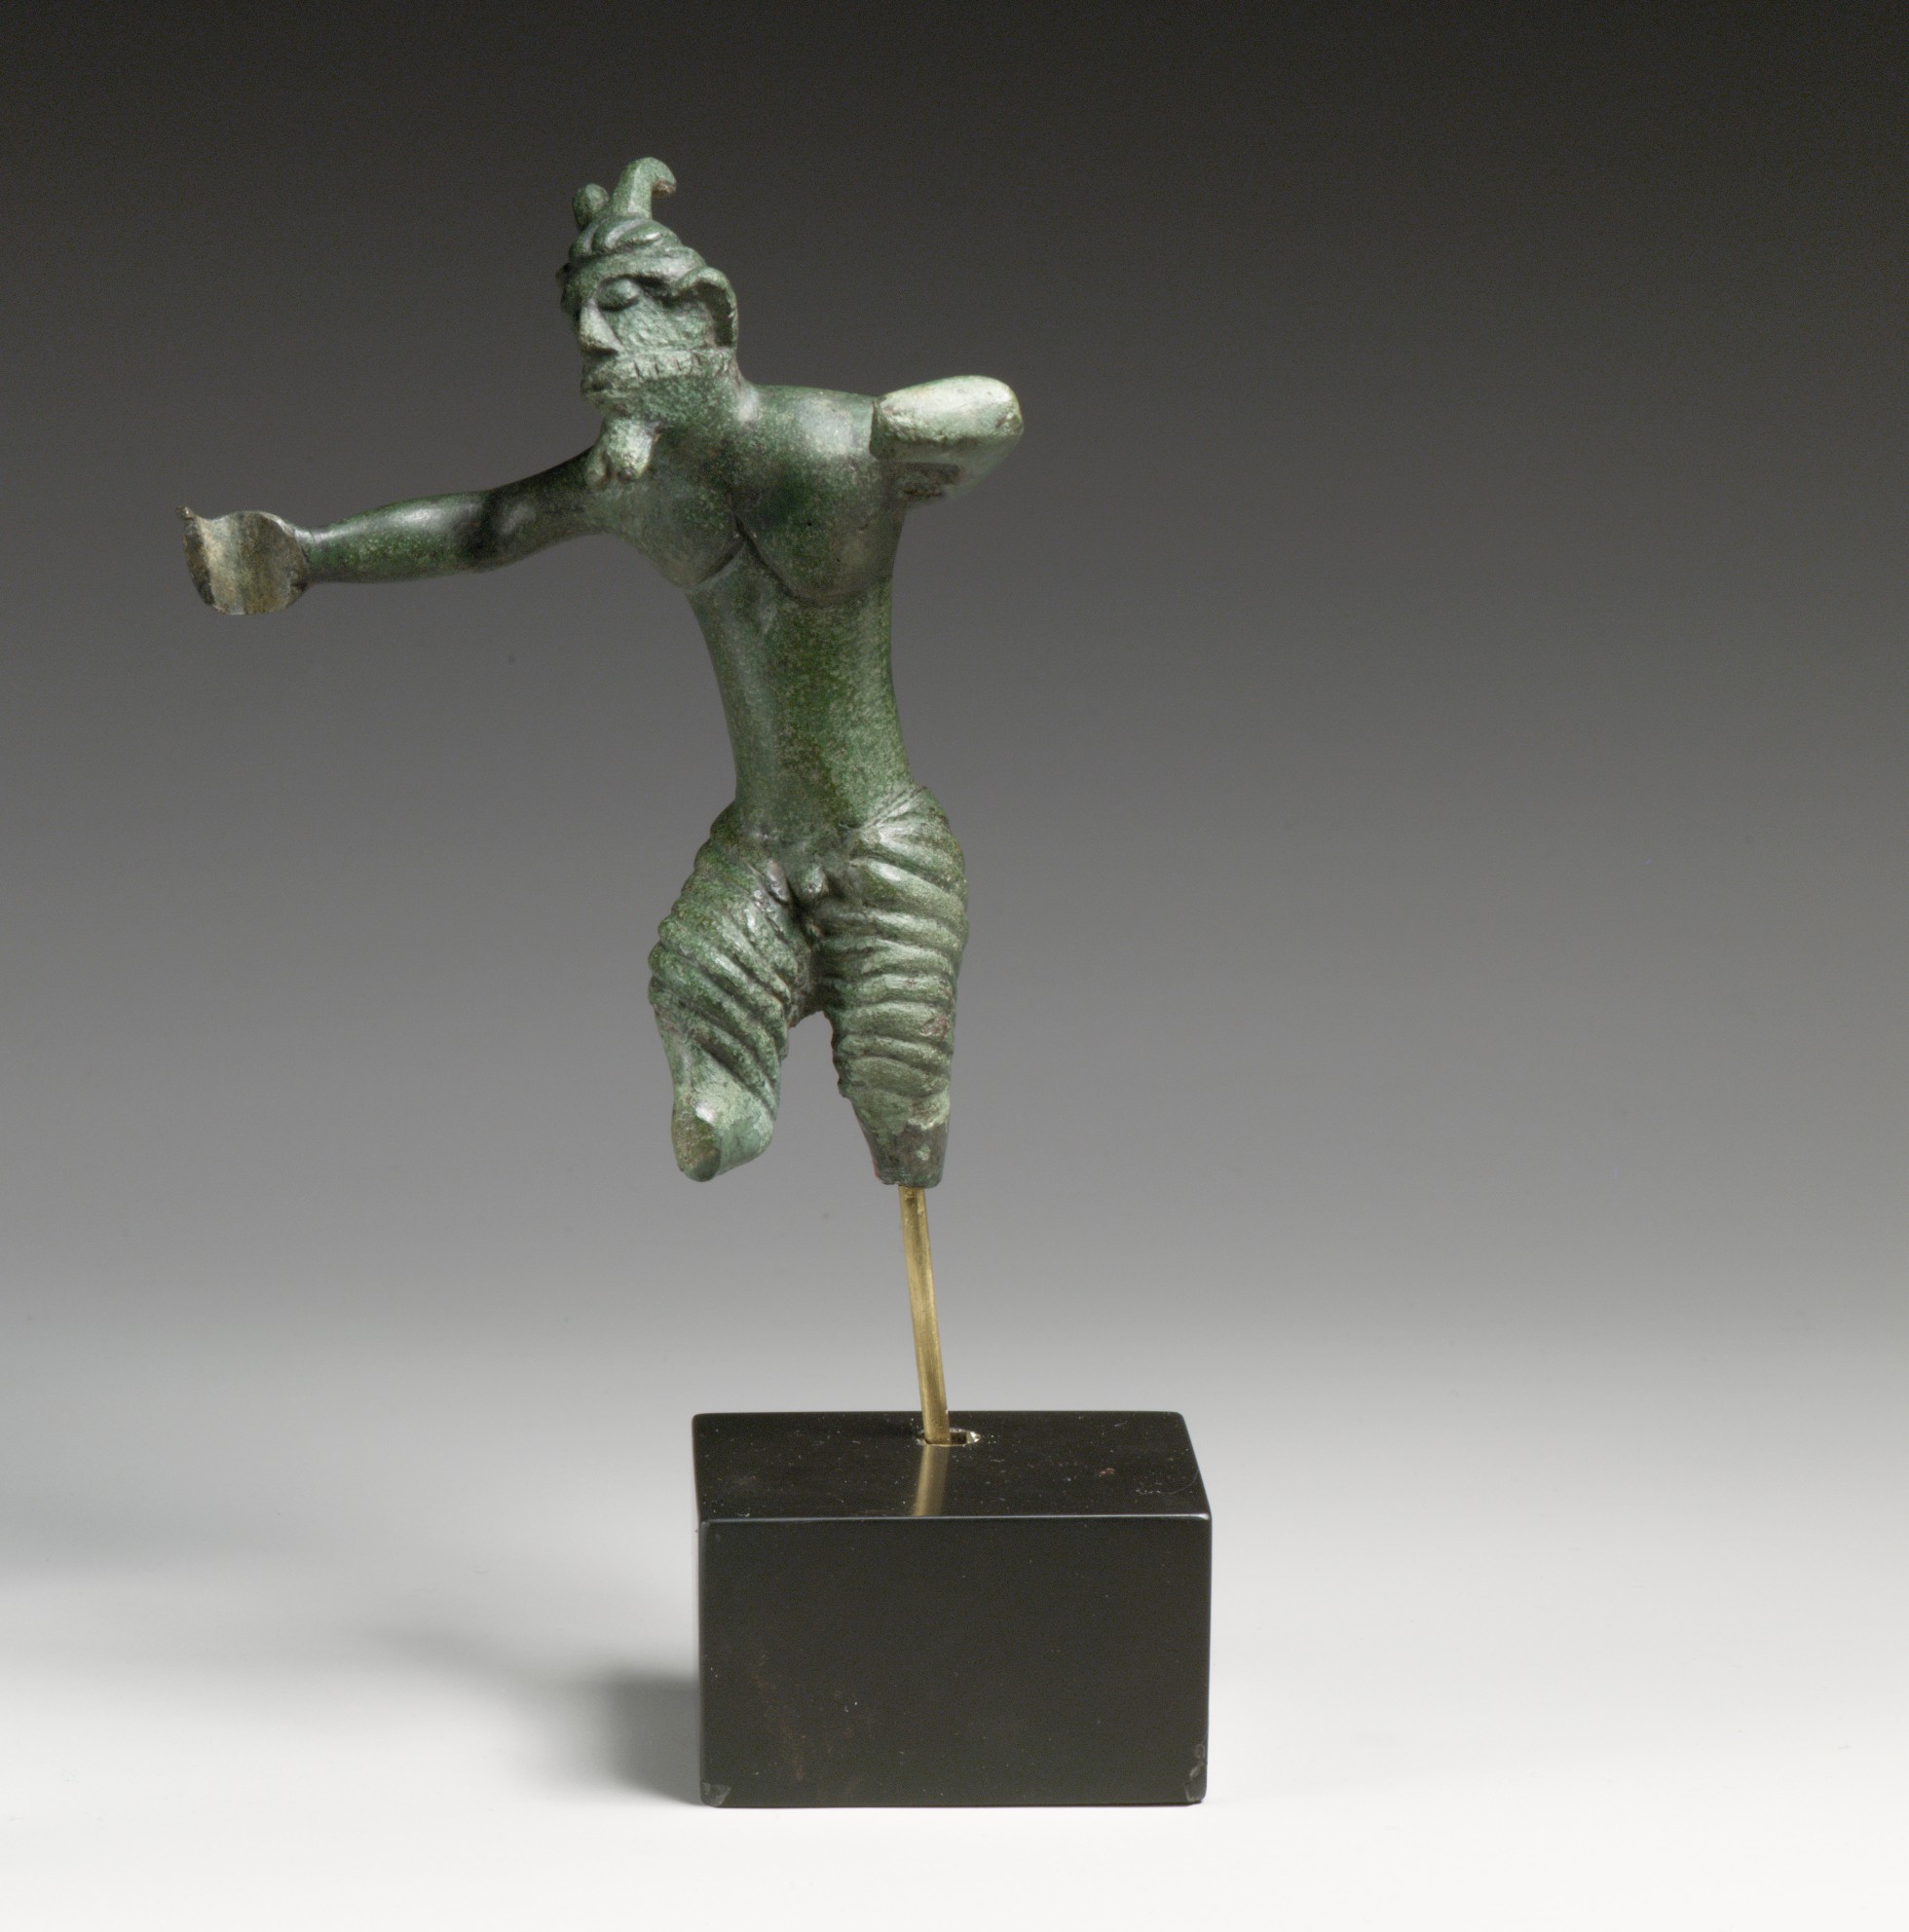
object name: statuette of pan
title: Bronze statuette of Pan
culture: greek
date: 434-301 BCE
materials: bronze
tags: men